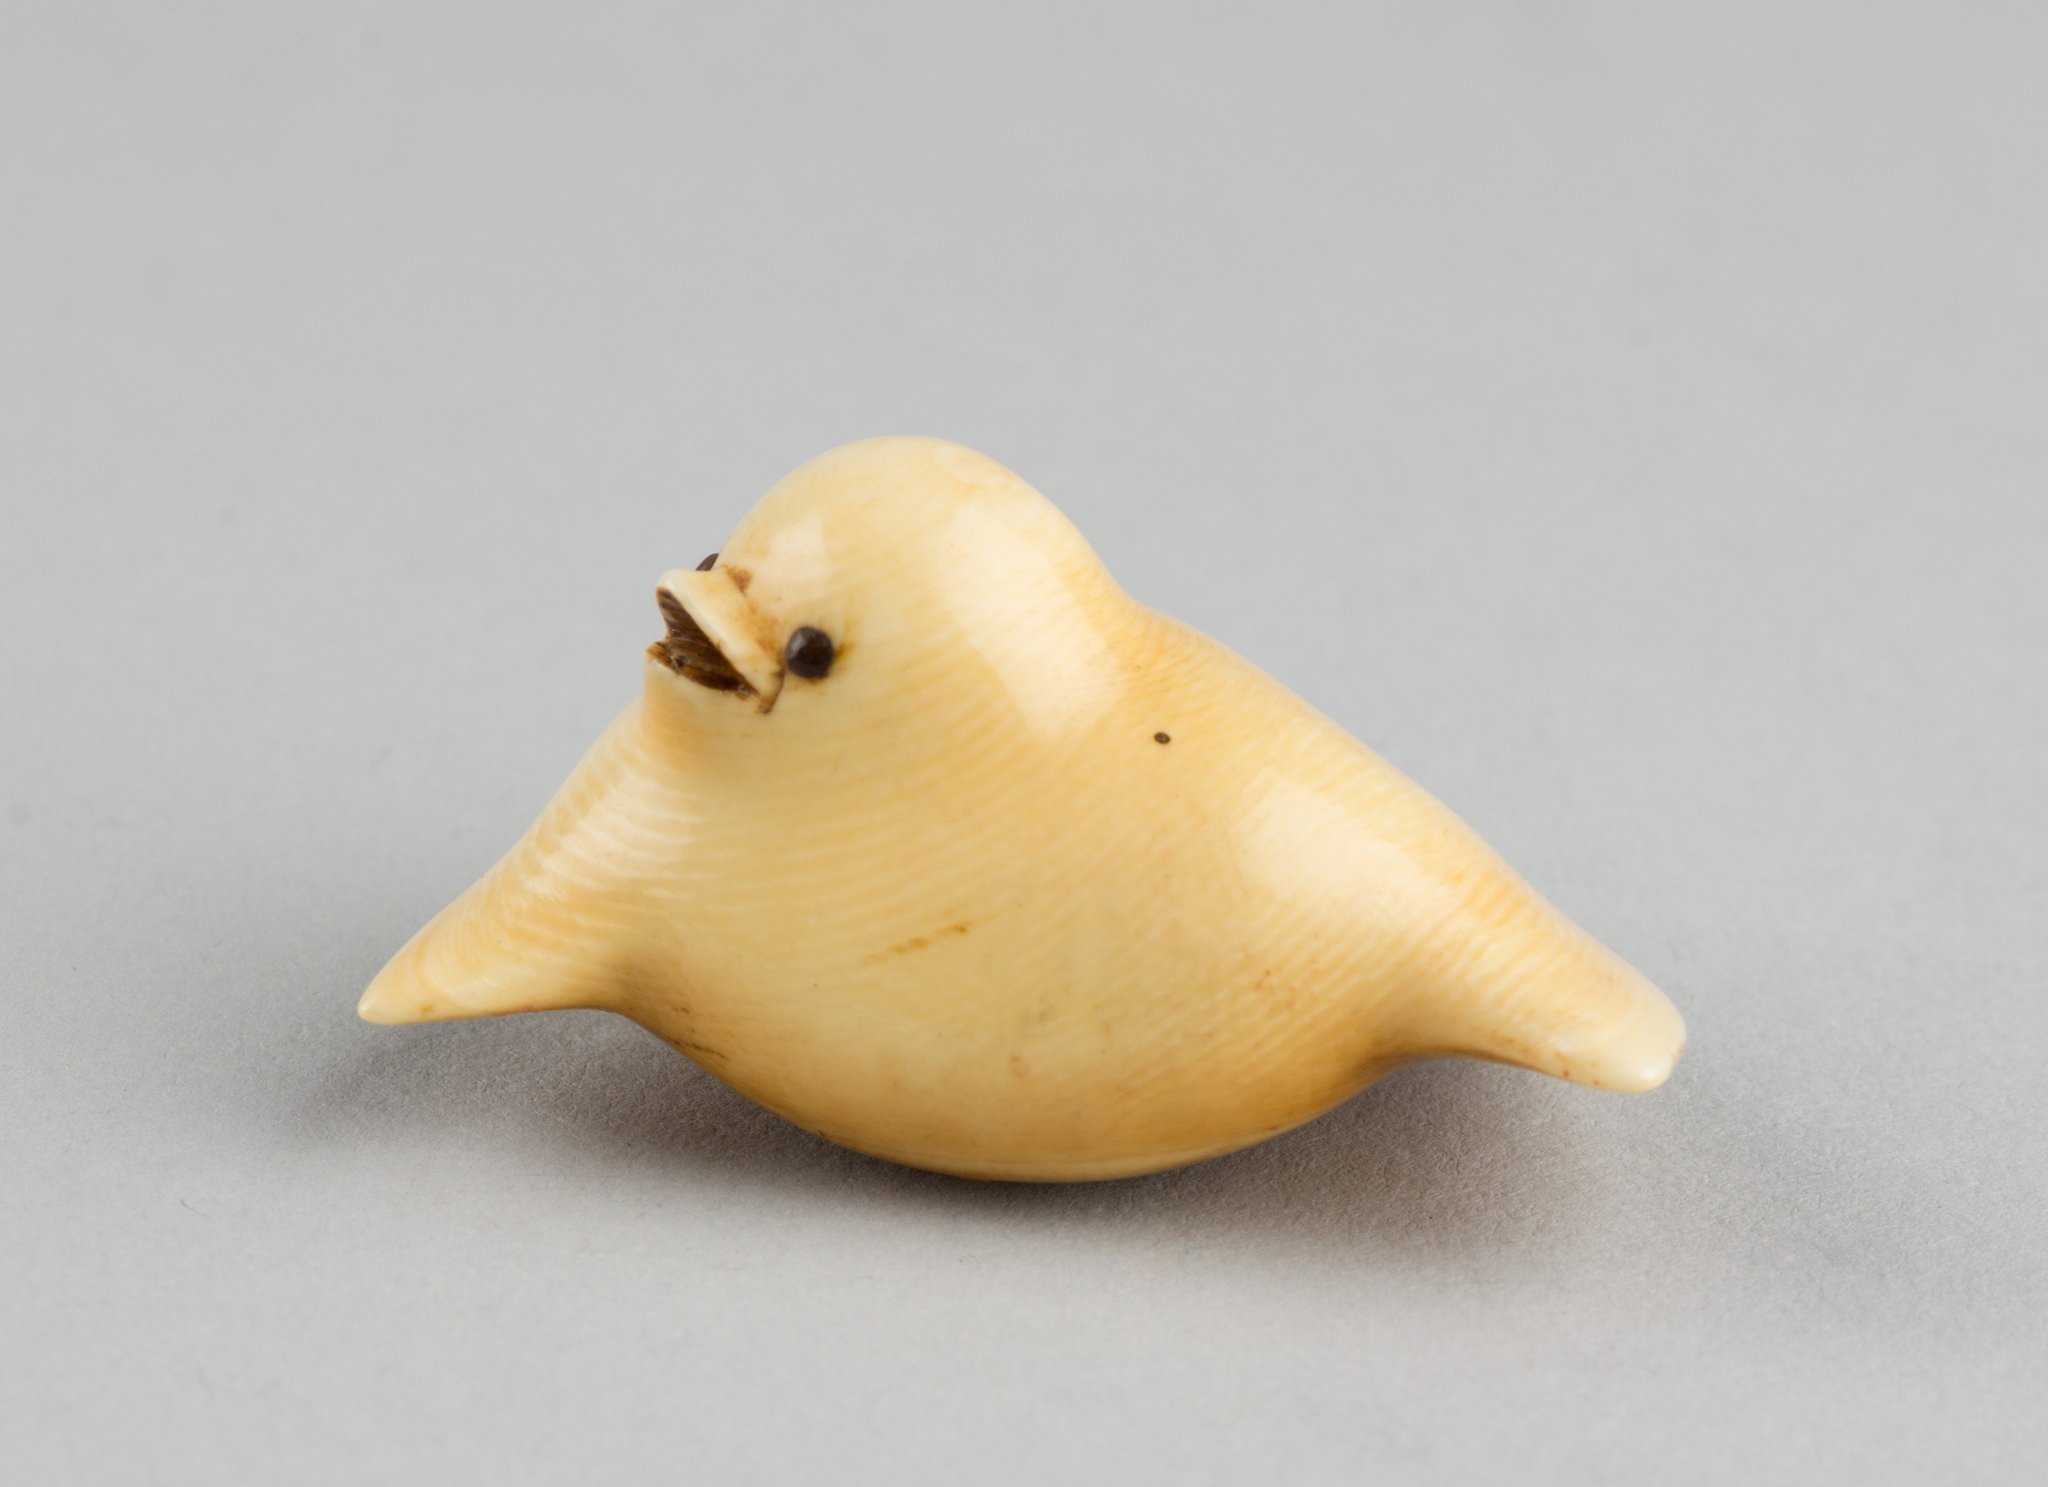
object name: netsuke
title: Netsuke of Young Sparrow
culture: japanese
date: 1801-1900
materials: ivory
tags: birds